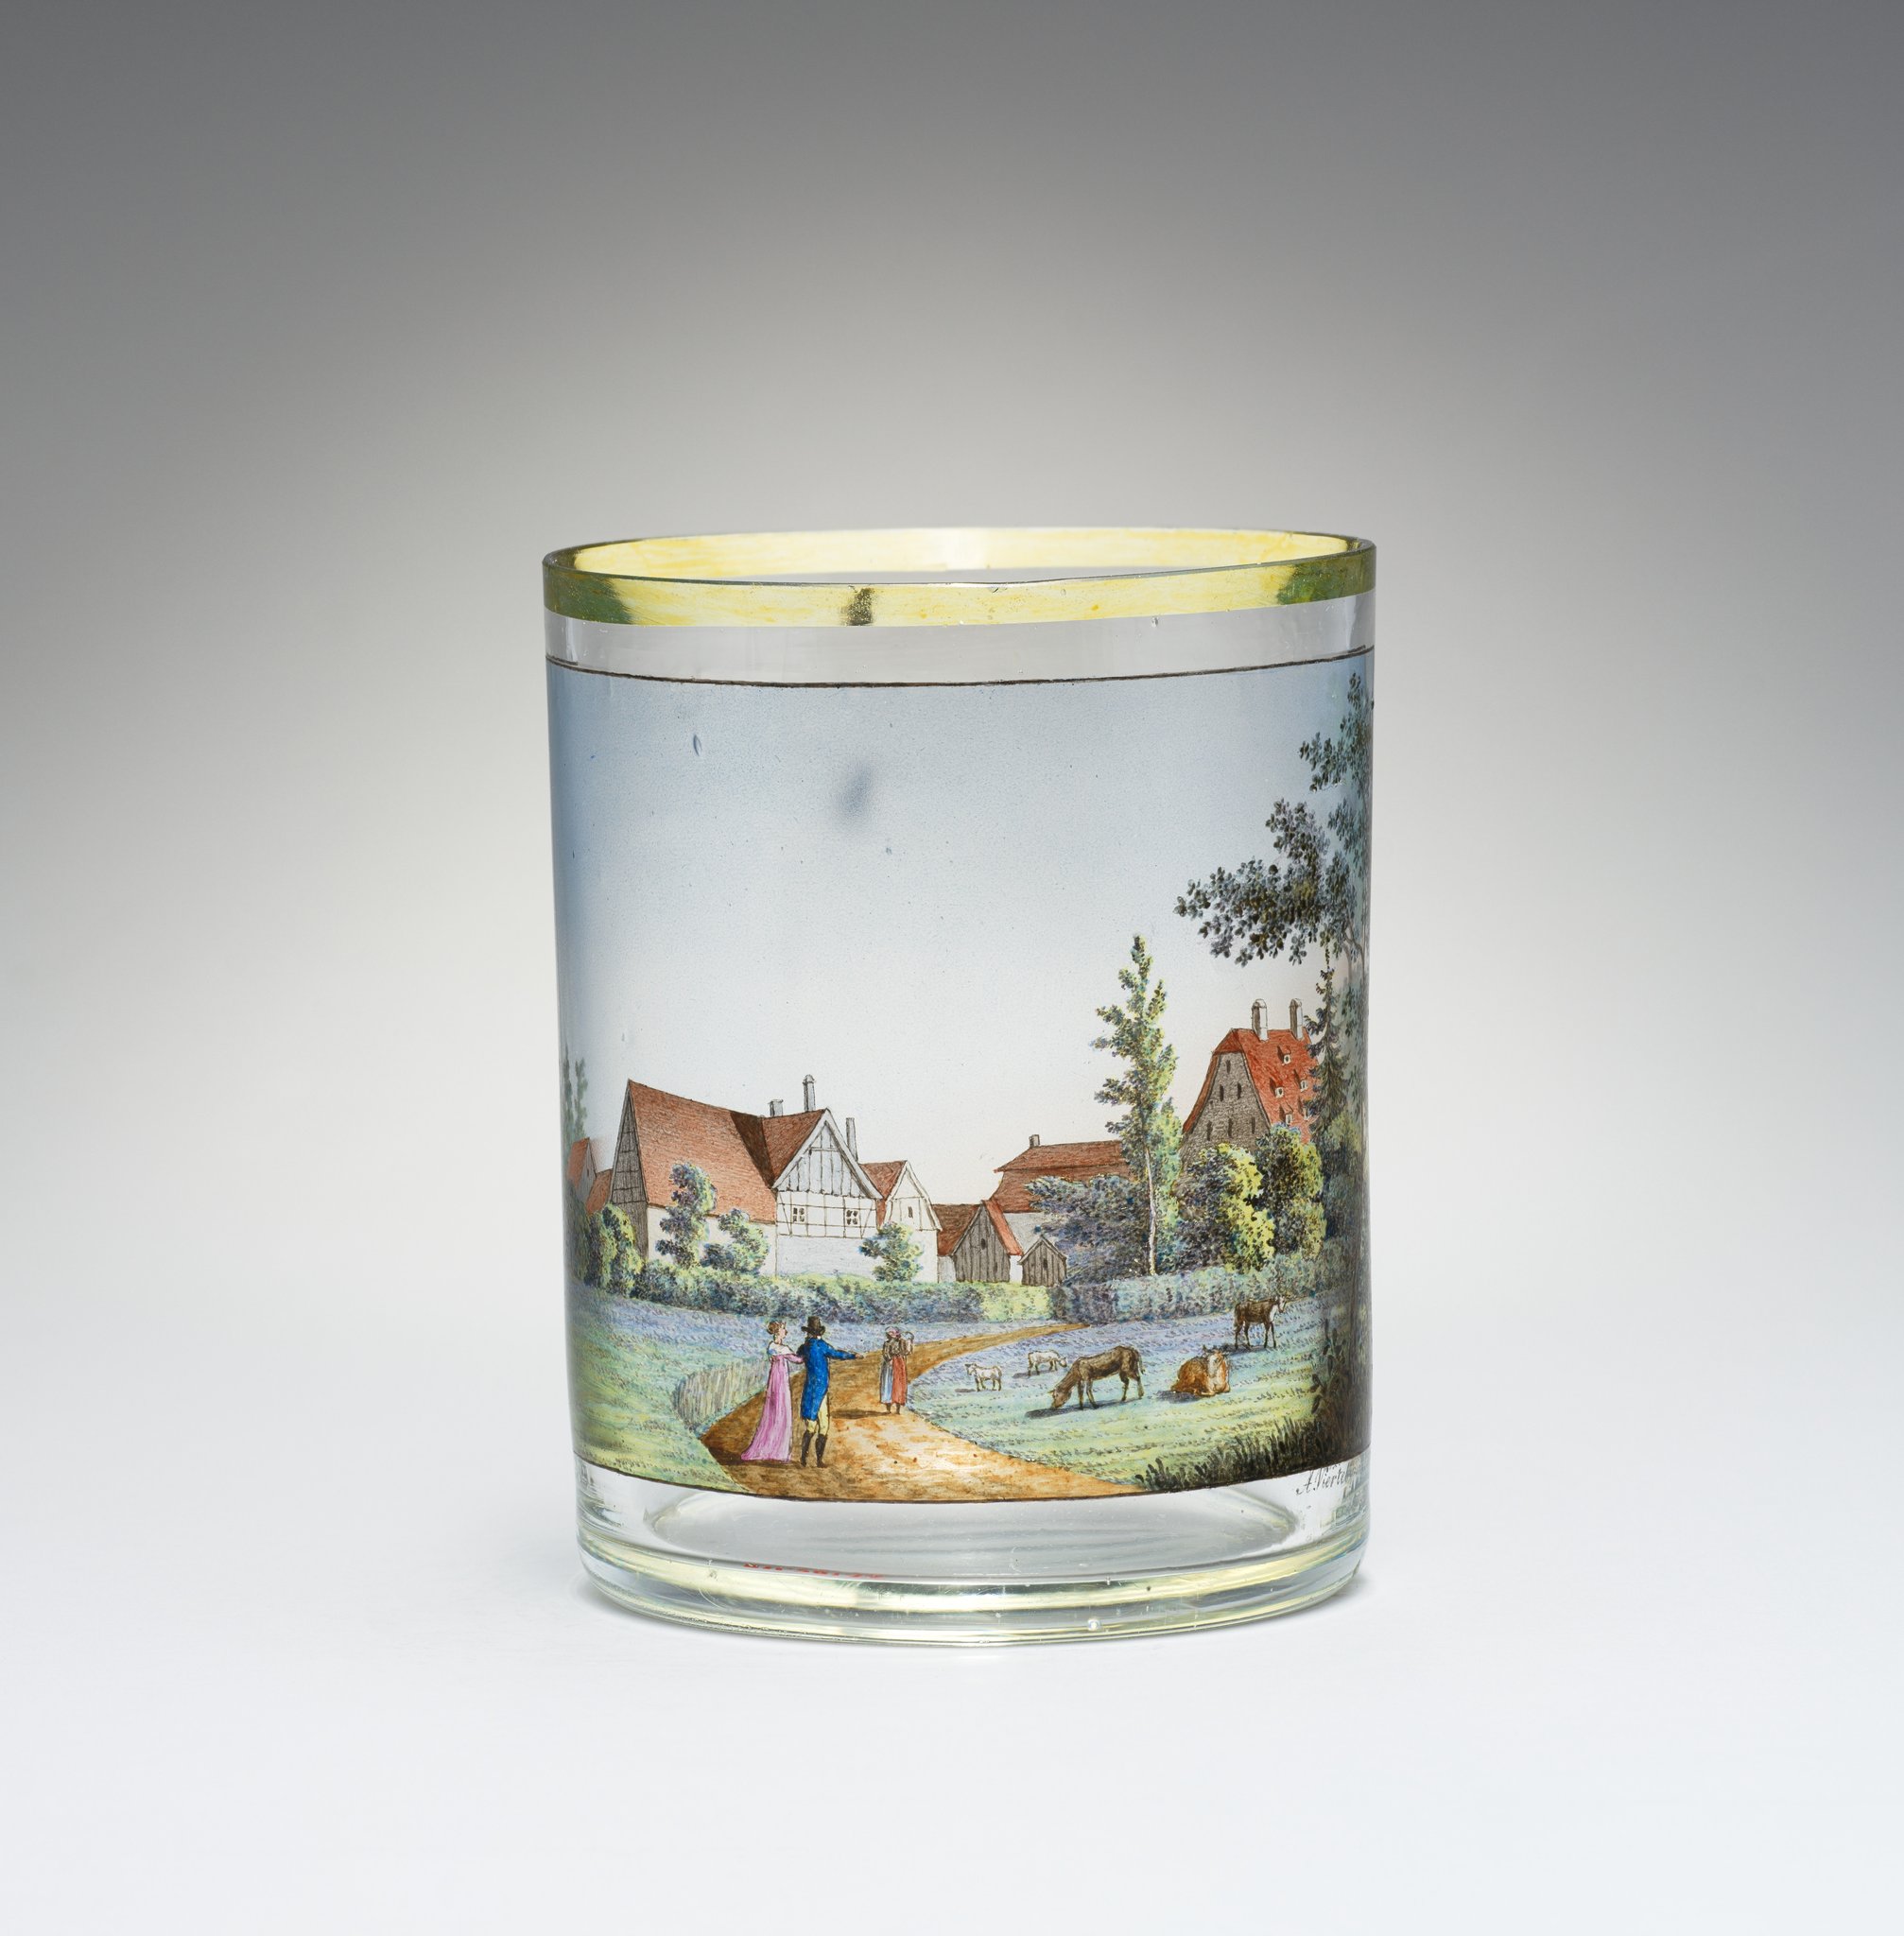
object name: beaker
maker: august viertel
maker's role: enameler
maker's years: 1750-1850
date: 1810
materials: glass